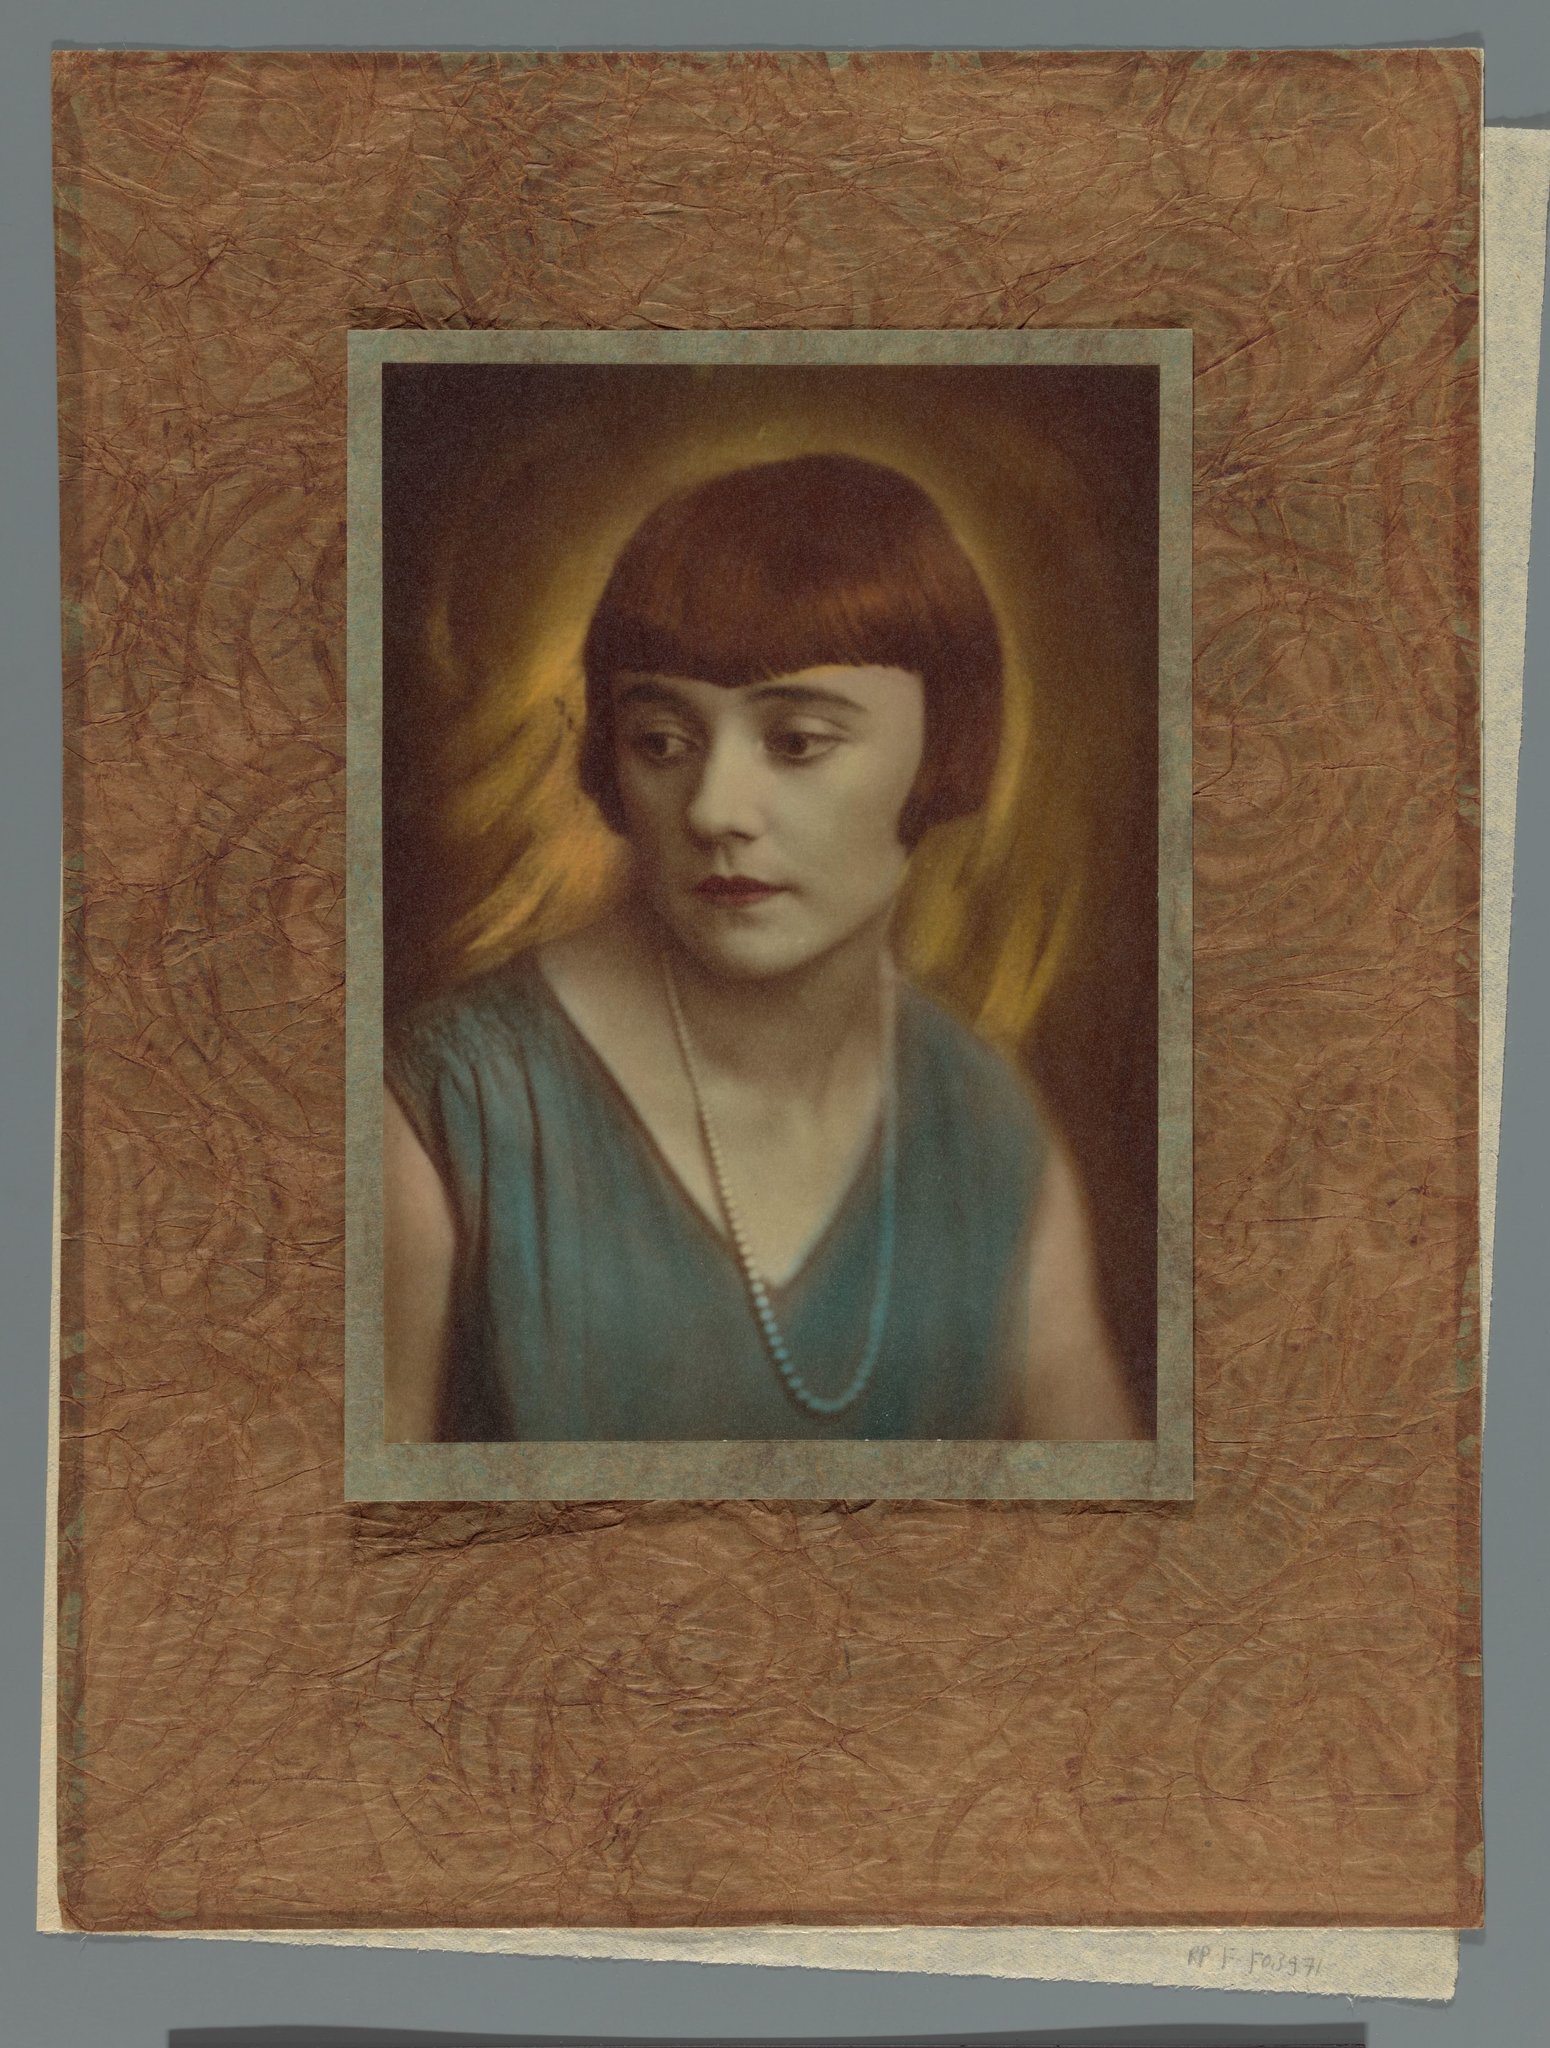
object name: photograph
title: Portret van jonge vrouw met ketting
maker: jacob merkelbach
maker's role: fotograaf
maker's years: 1877-1942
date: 1920-1930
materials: cardboard, paper, photographic support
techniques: jos-pé print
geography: amsterdam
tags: historical persons not known by name - bb - woman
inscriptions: inscription: ‘Mej. N.N.’